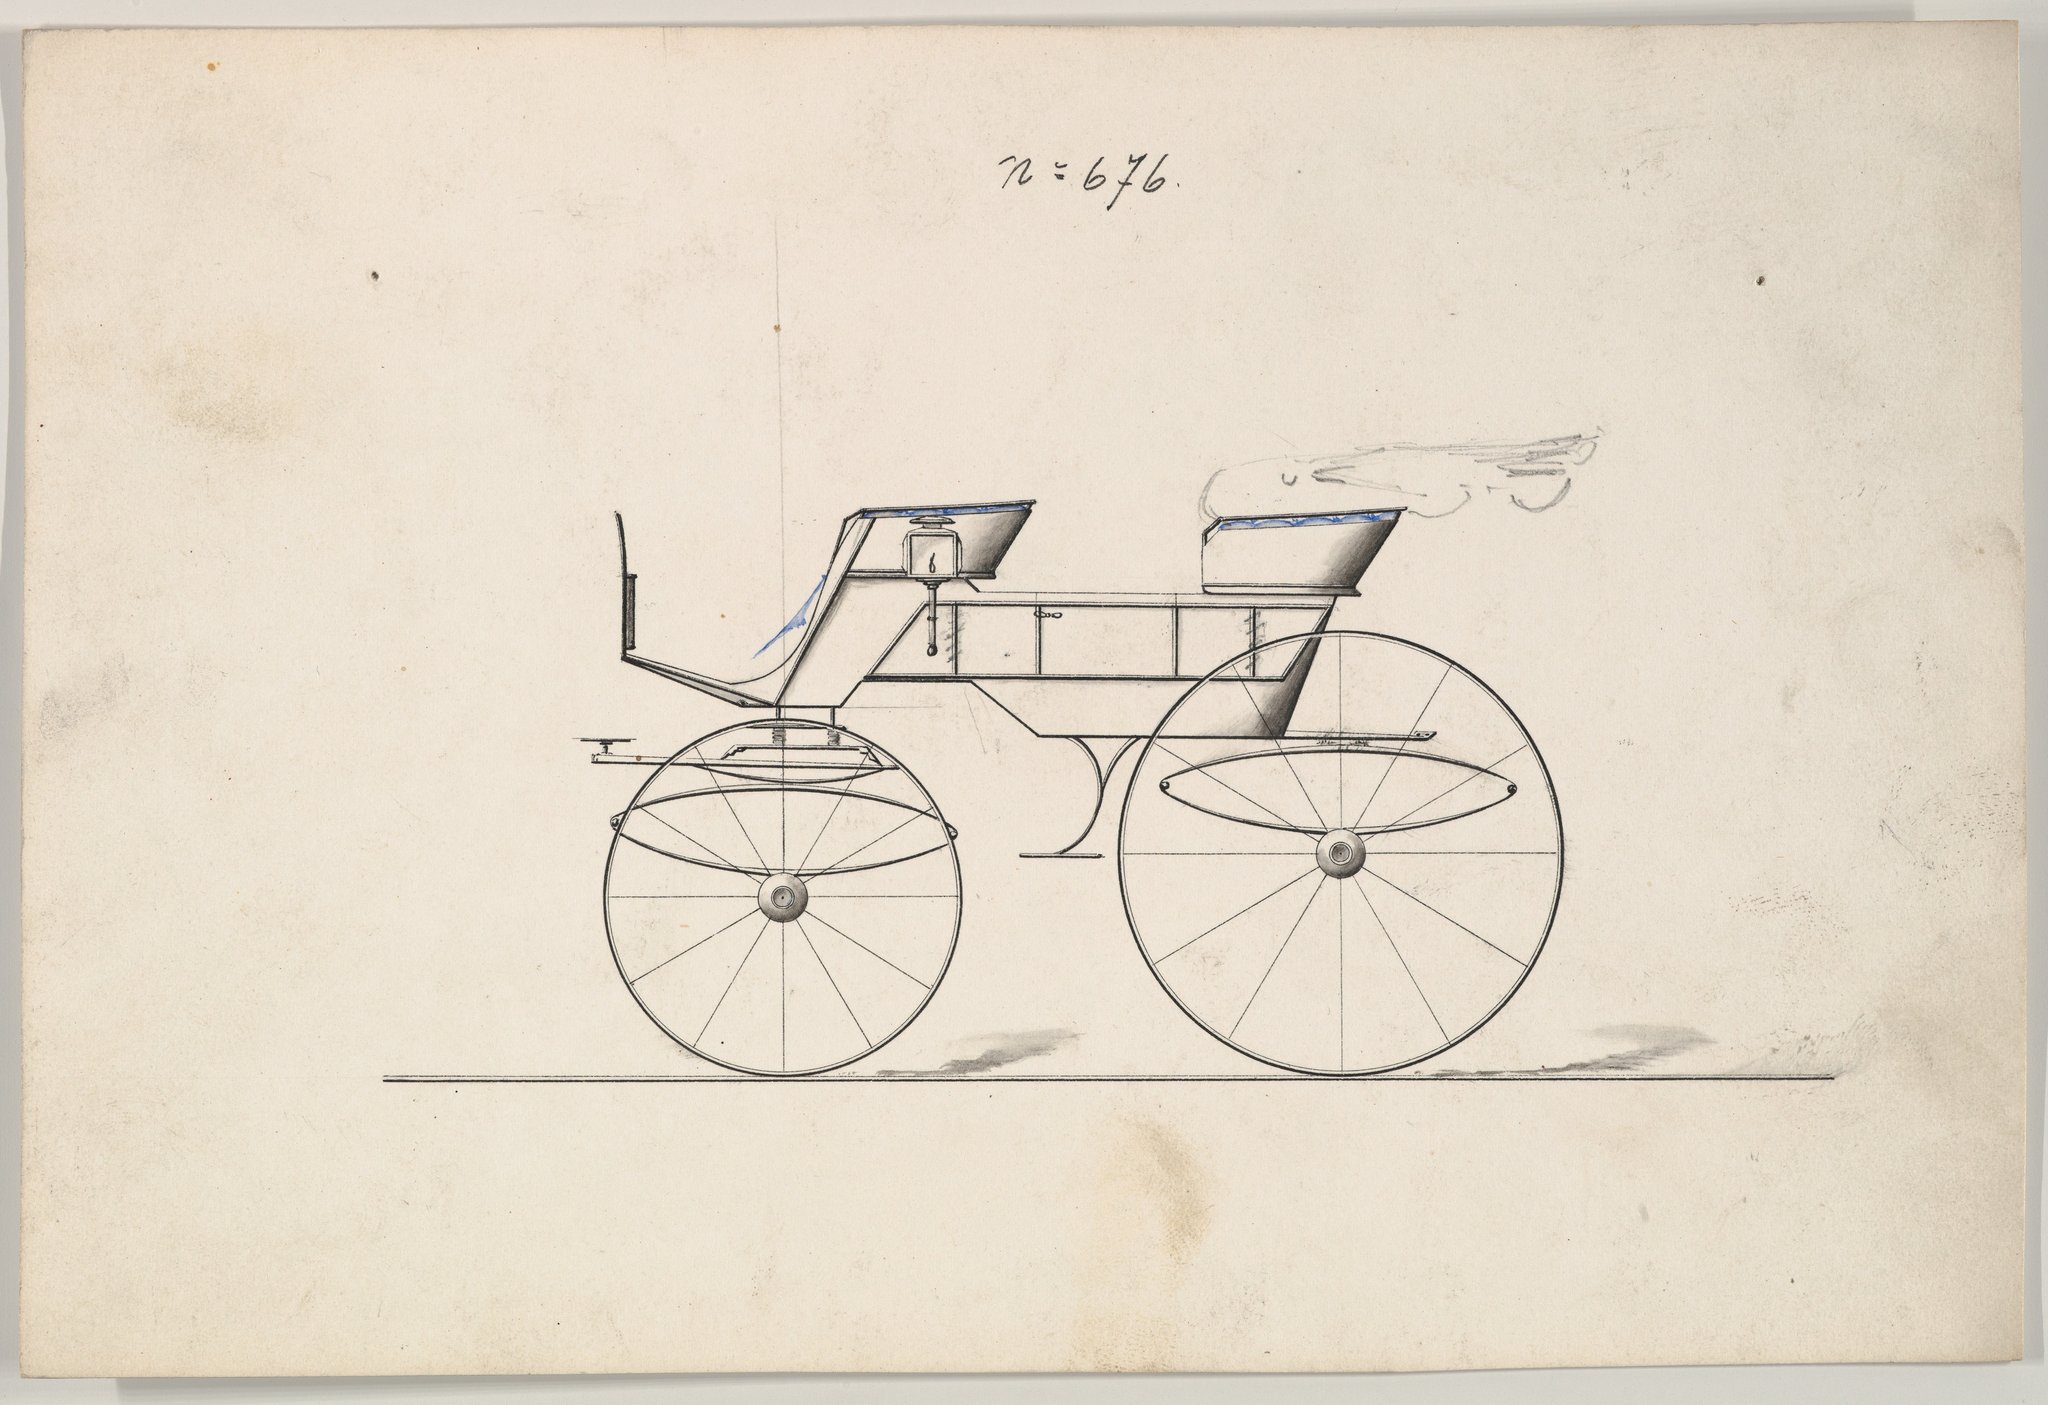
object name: drawing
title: Design for Phaeton, no. 676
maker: brewster & co.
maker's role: manufacturer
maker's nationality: american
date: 1850-1874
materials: gouache, graphite, ink, watercolor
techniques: pen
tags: carriages